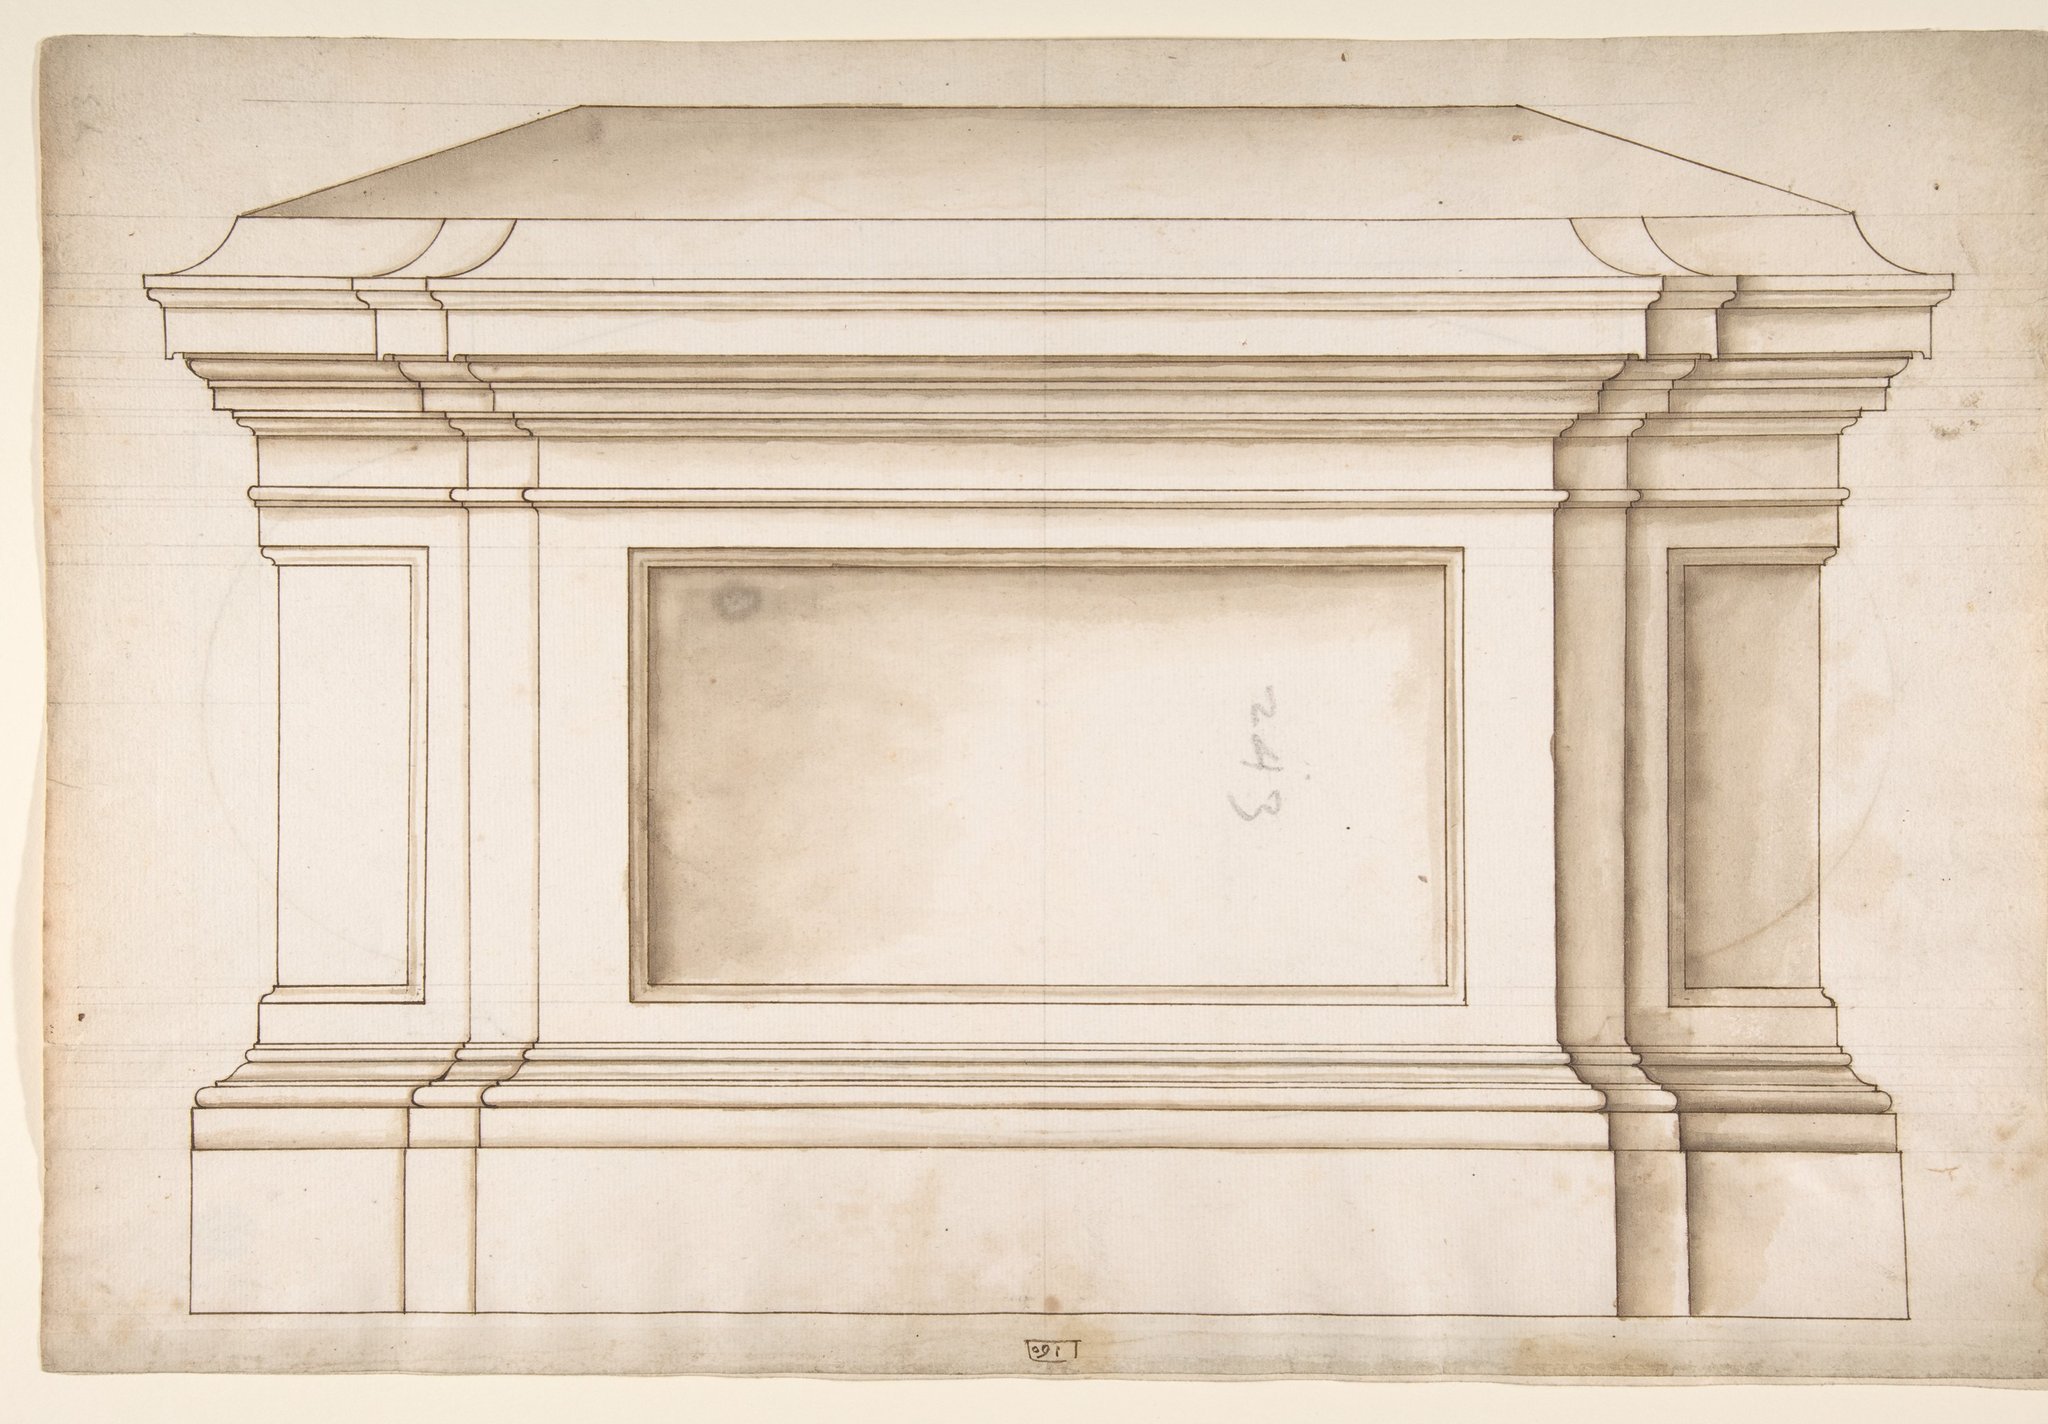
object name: drawing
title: Marcus Aurelius Statue, pedestal, elevation (recto) Marcus Aurelius Statue, pedestal, plan (verso)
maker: anonymous, french, 16th century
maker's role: draftsman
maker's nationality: french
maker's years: 1500-1600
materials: chalk, ink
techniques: incising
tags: architecture